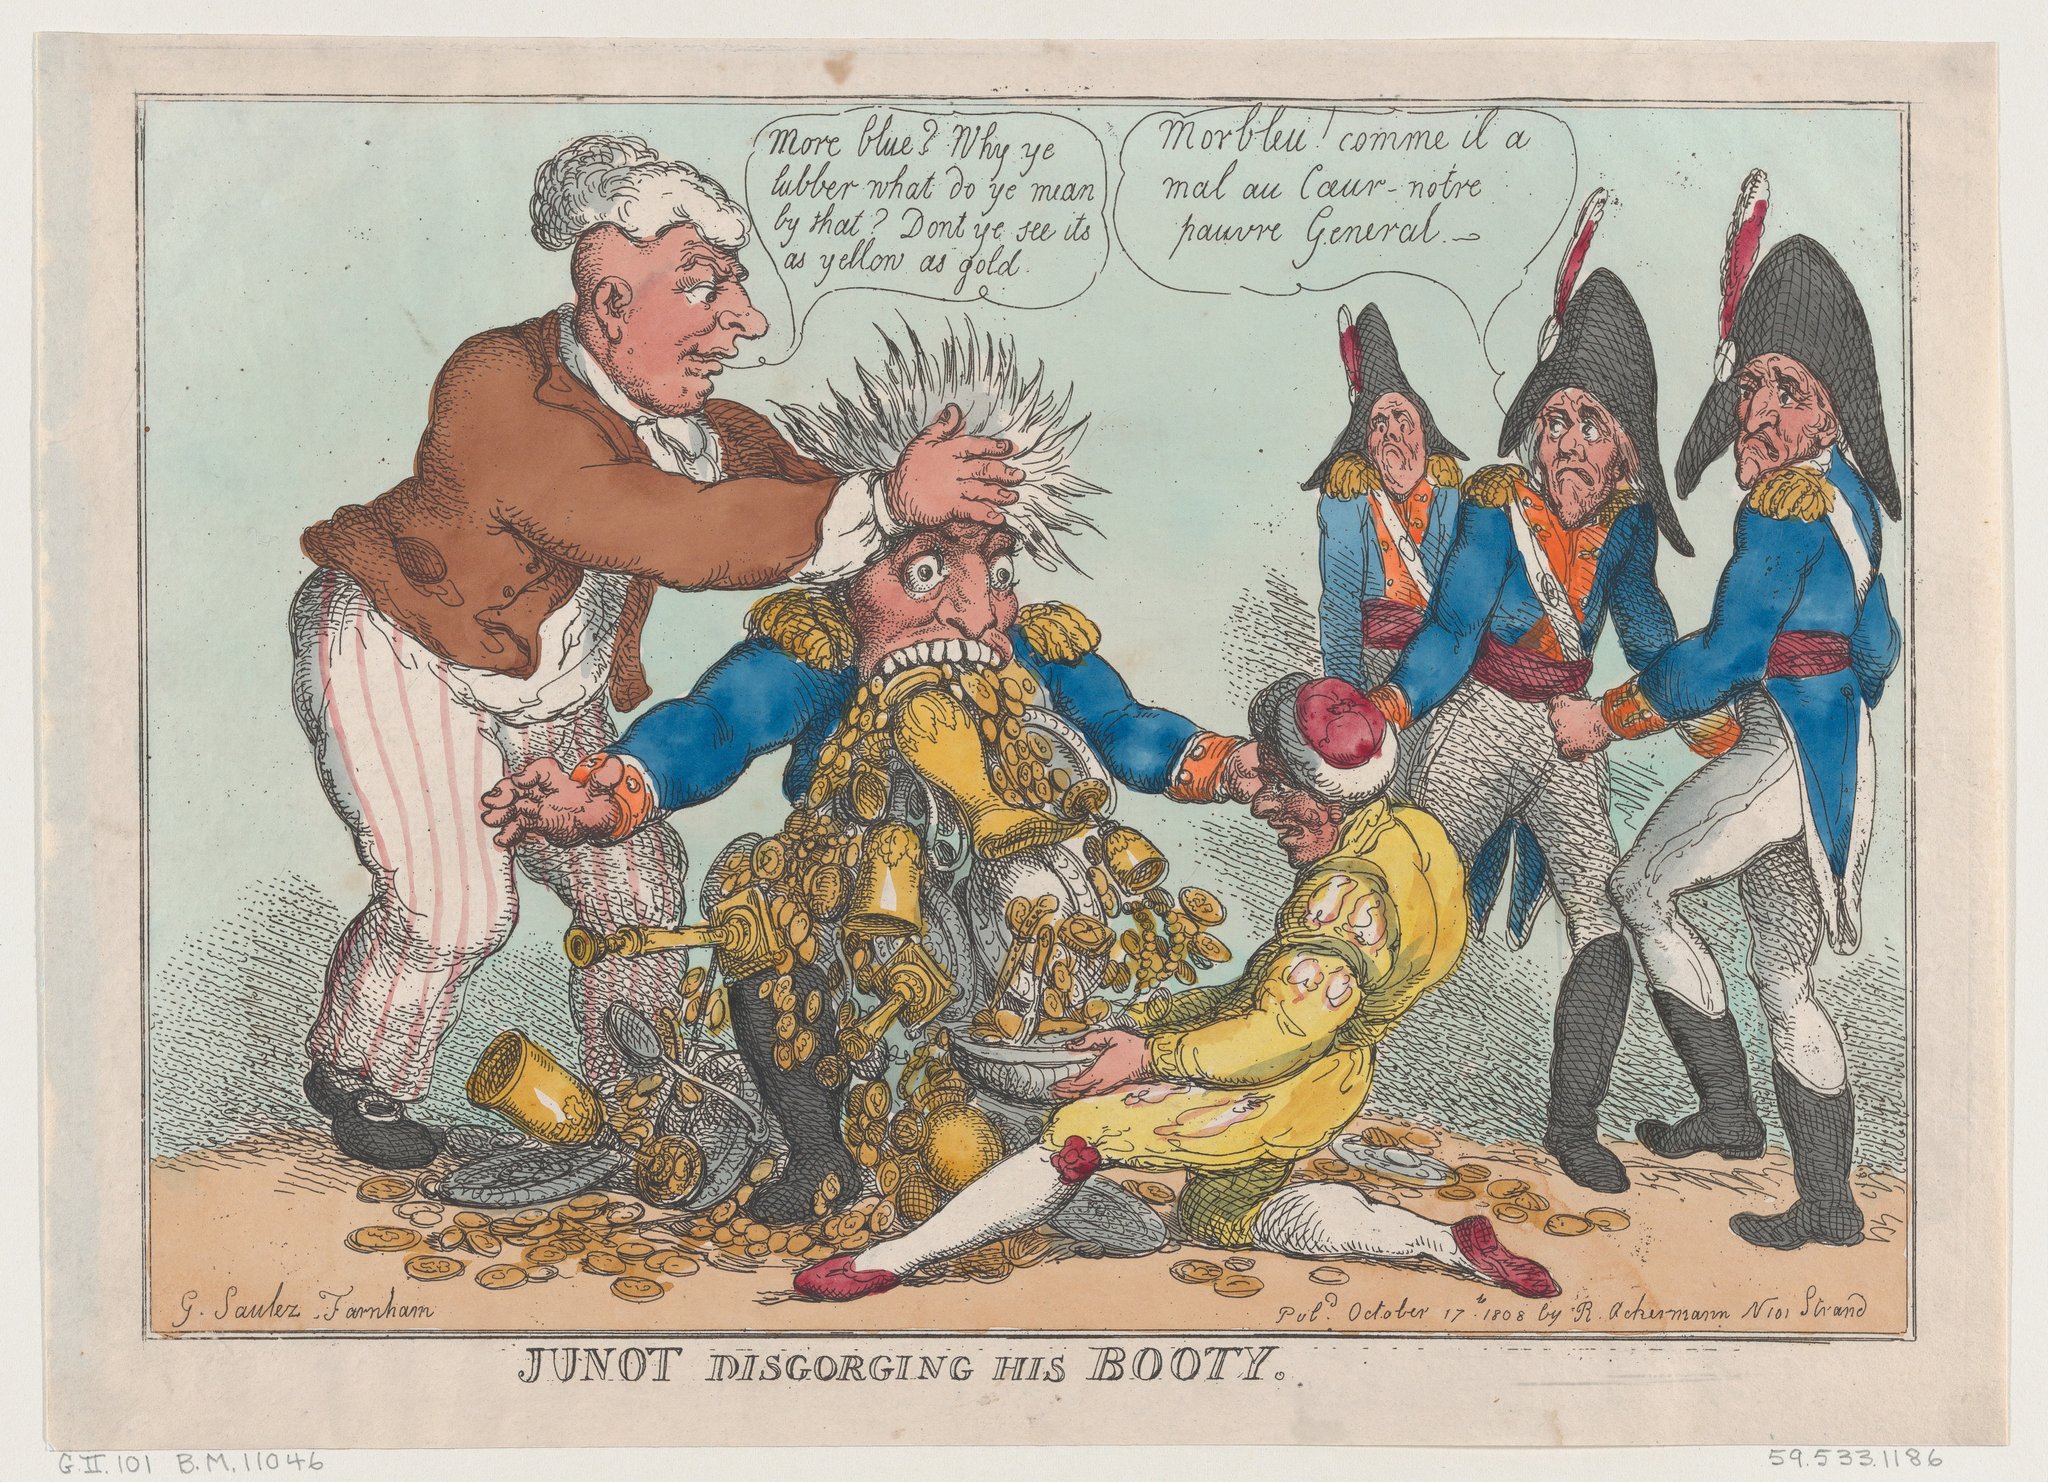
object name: print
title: Junot Disgorging His Booty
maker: thomas rowlandson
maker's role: artist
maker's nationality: british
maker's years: 1757-1827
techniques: etching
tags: satire,soldiers,men,politics